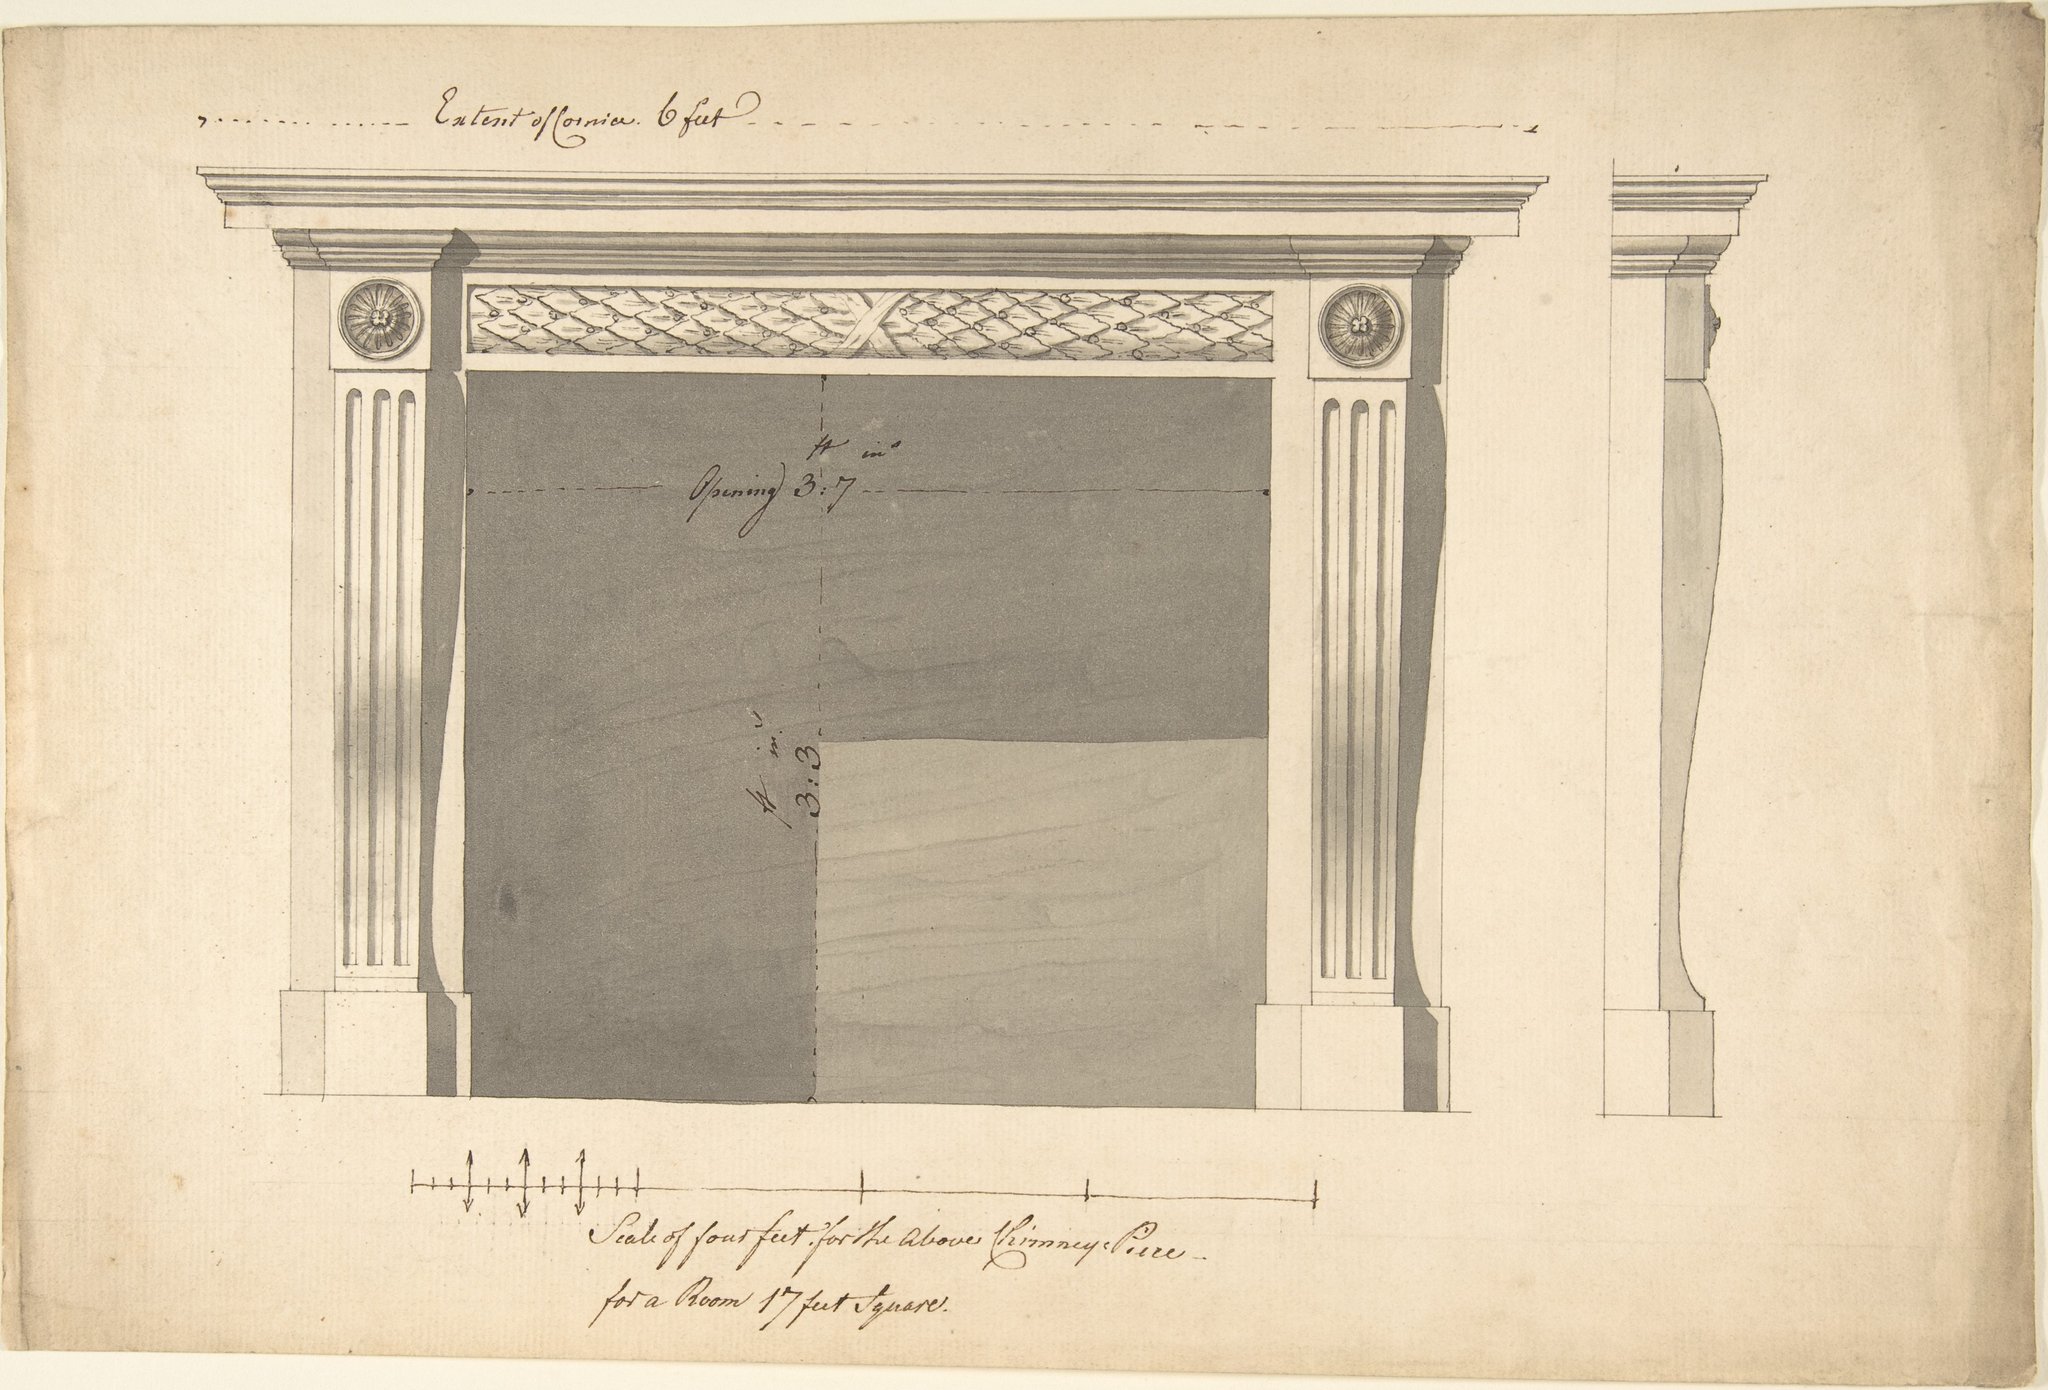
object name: drawing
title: Design for a Chimneypiece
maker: sir william chambers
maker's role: artist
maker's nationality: british, born sweden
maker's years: 1723-1796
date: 1740-1800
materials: ink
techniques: brush, pen, wash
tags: fireplaces